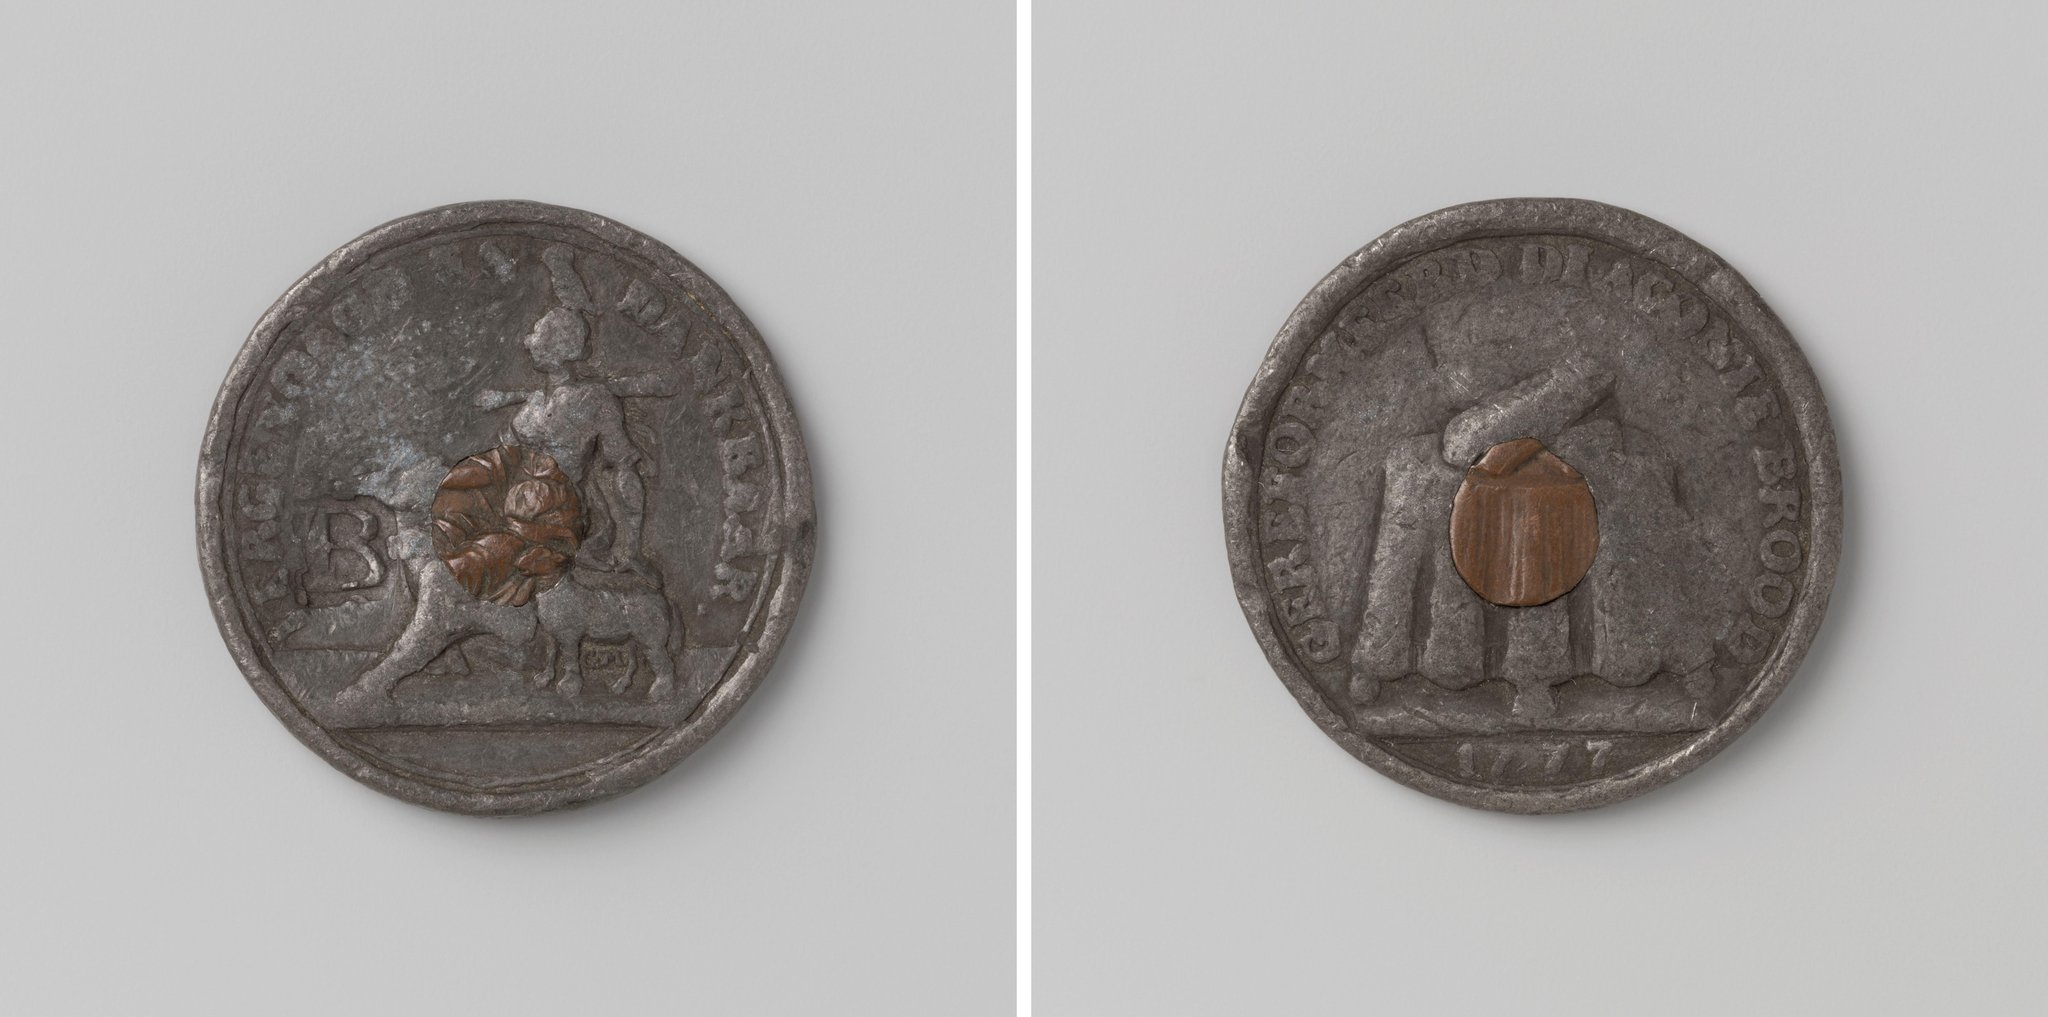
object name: alms token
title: Gereformeerde Diakonie te Amsterdam, armenpenning die behoeftige kerklidmaten bij uitdeling recht gaf op brood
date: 1777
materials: copper, lead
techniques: striking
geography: amsterdam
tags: amsterdam